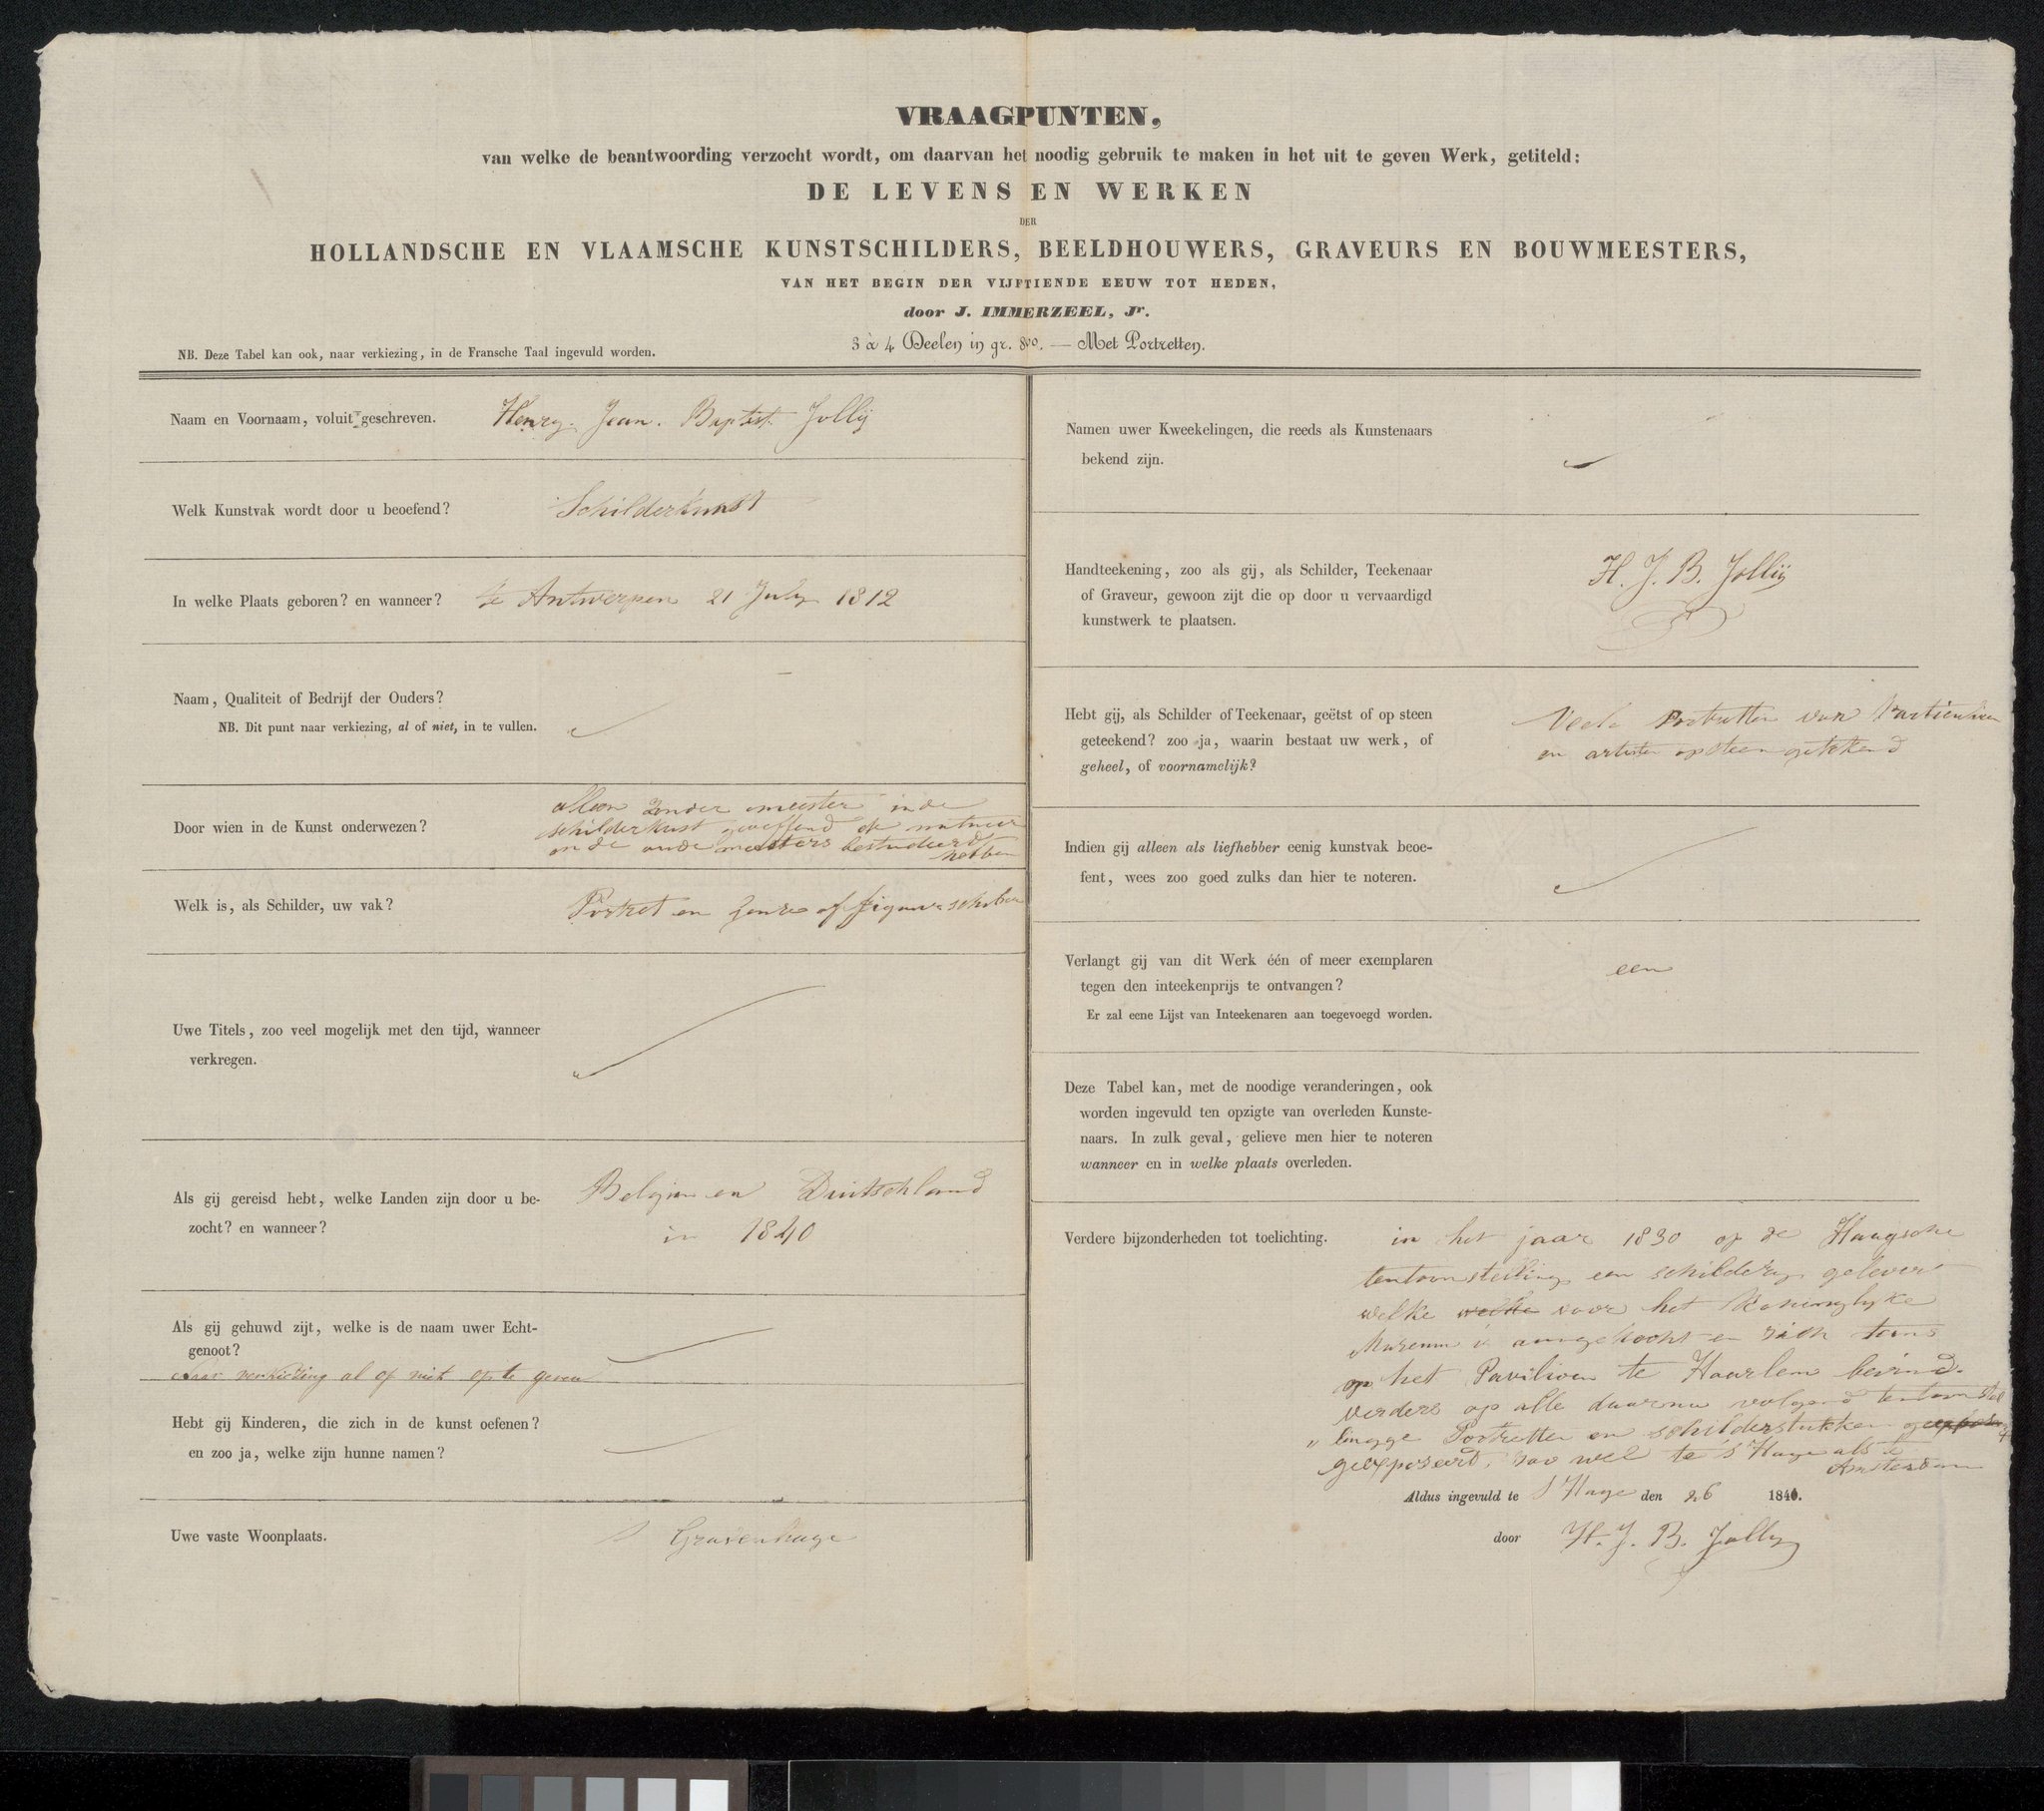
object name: manuscript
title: Enquêteformulier ingevuld door Henri Jean Baptiste Jolly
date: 1841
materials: ink, paper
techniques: pen, printing, writing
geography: the hague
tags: antwerp, amsterdam, painter, draughtsman, henri jean baptiste jolly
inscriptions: inscription: ‘Vraagpunten,/ van welke de beantwoording verzocht wordt, om daarvan het noodig gebruik te maken in het uit te geven Werk, getiteld: De levens en werken/ der Hollandsche en Vlaamsche kunstschilders, beeldhouwers,/ graveurs en bouwmeesters, van het begin der vijftiende eeuw tot heden/ door J. Immerzeel, Jr.’, watermark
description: Opgenomen in: Immerzeel, J. Jr., De levens en werken der Hollandsche en Vlaamsche kunstschilders, beeldhouwers, graveurs en bouwmeesters, van het begin der vijftiende eeuw tot heden, Amsterdam: J.C. van Kesteren, 1842-1843.